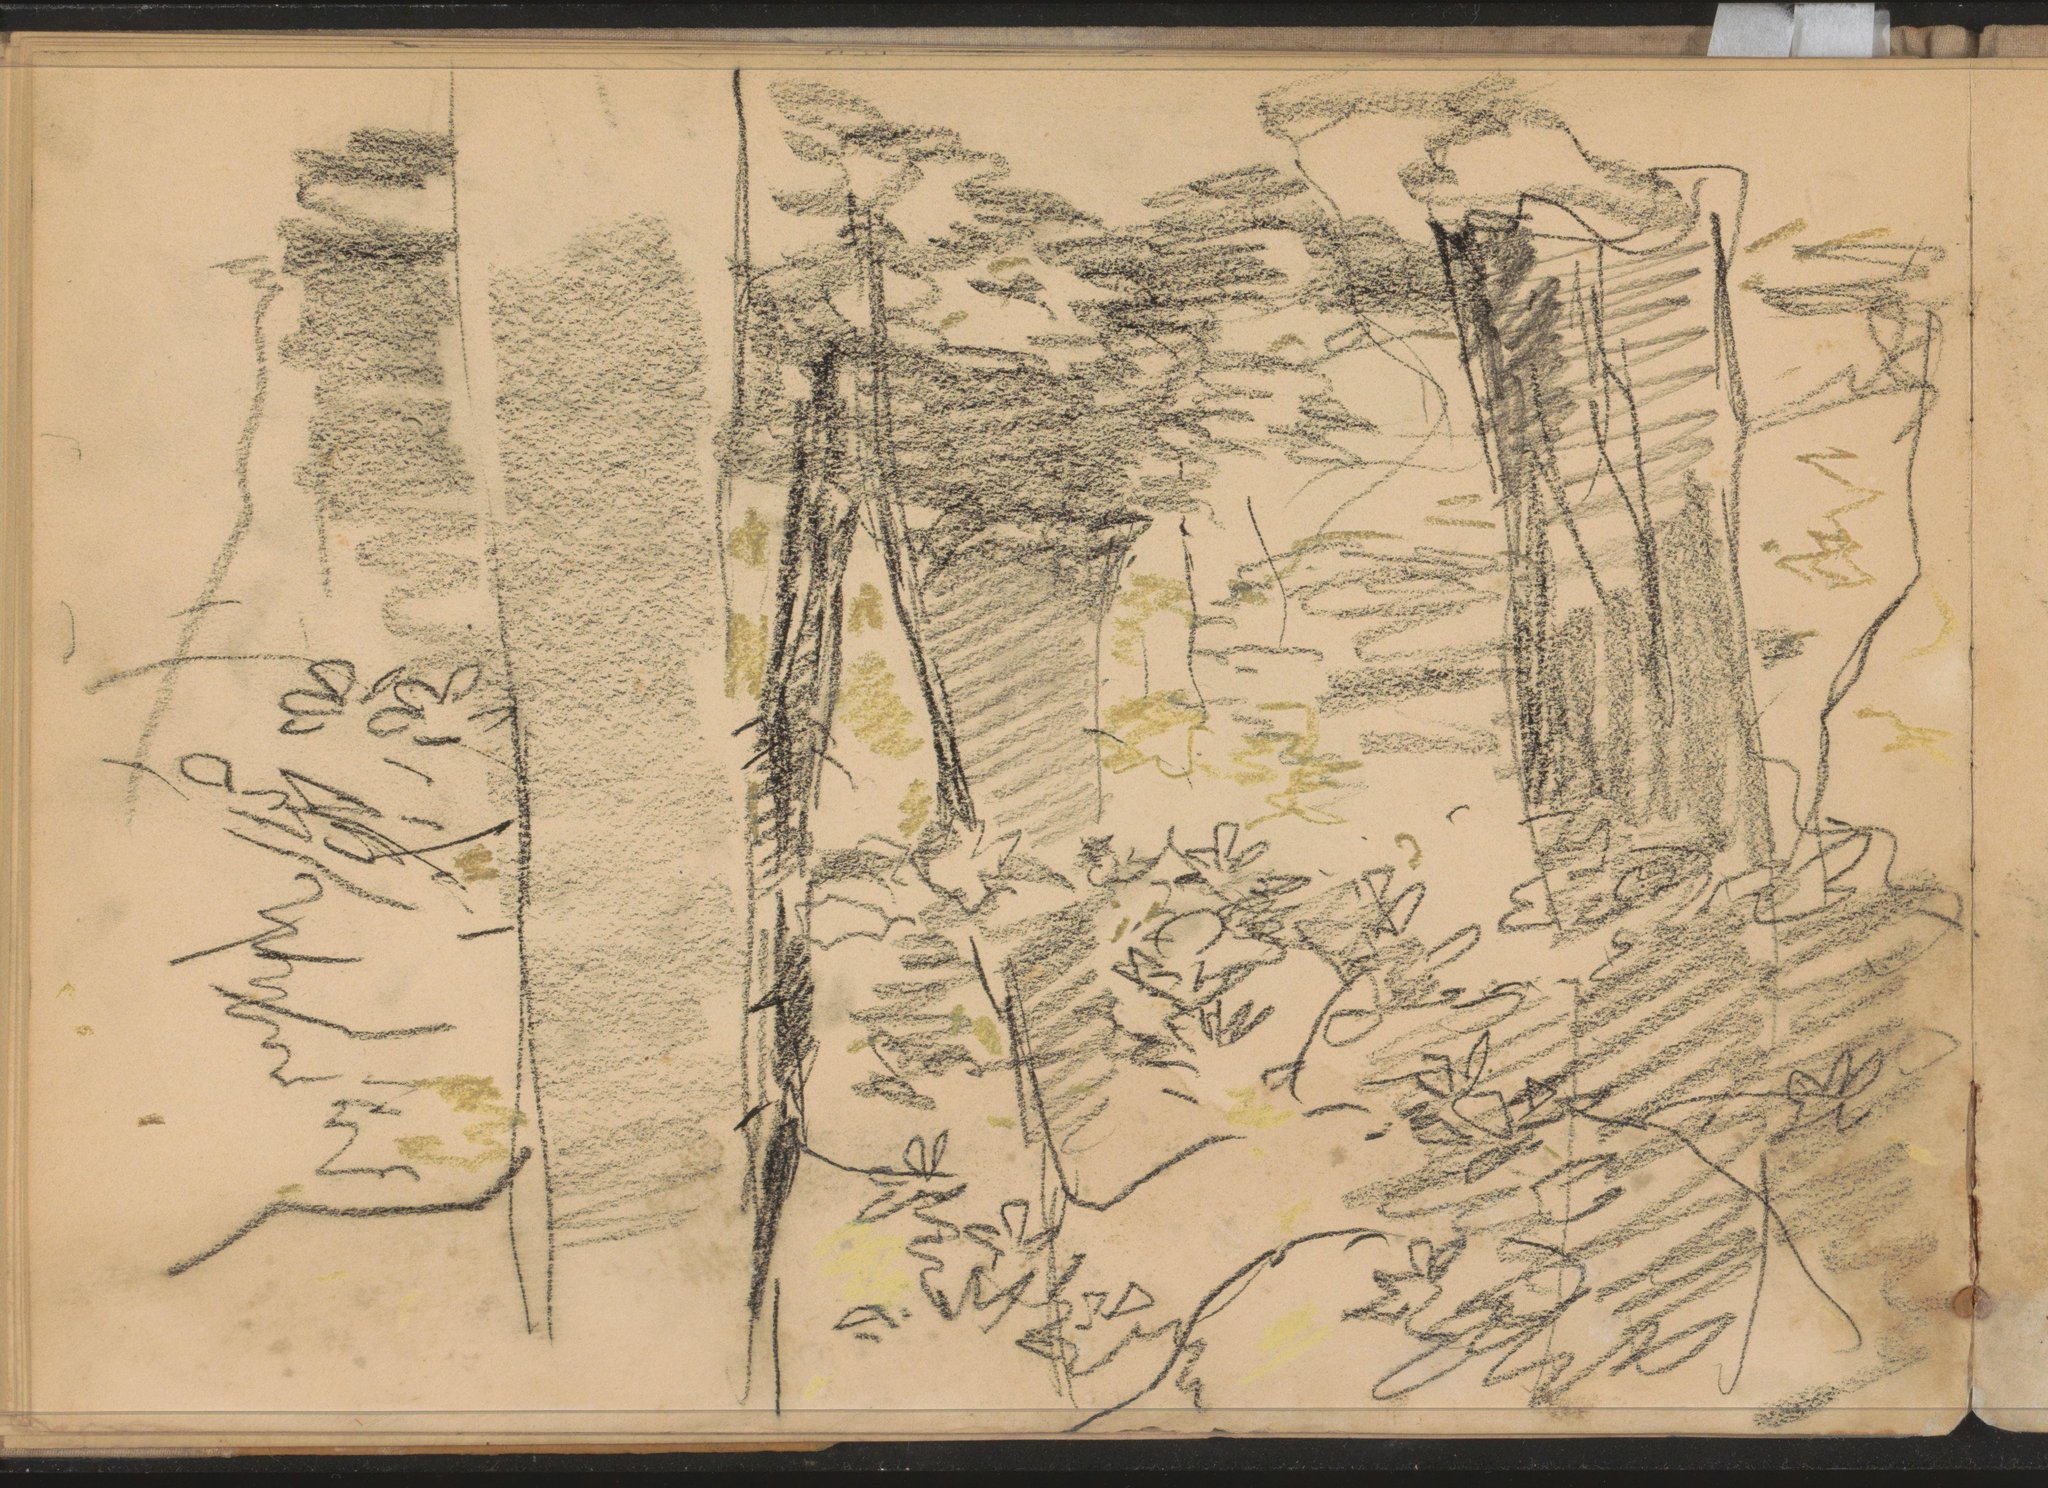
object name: sketchbook leaf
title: Bomen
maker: willem bastiaan tholen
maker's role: draughtsman, painter, print maker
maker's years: 1860-1931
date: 1885-1931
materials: chalk, paper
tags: trees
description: Blad 24 verso uit een schetsboek met 28 bladen.